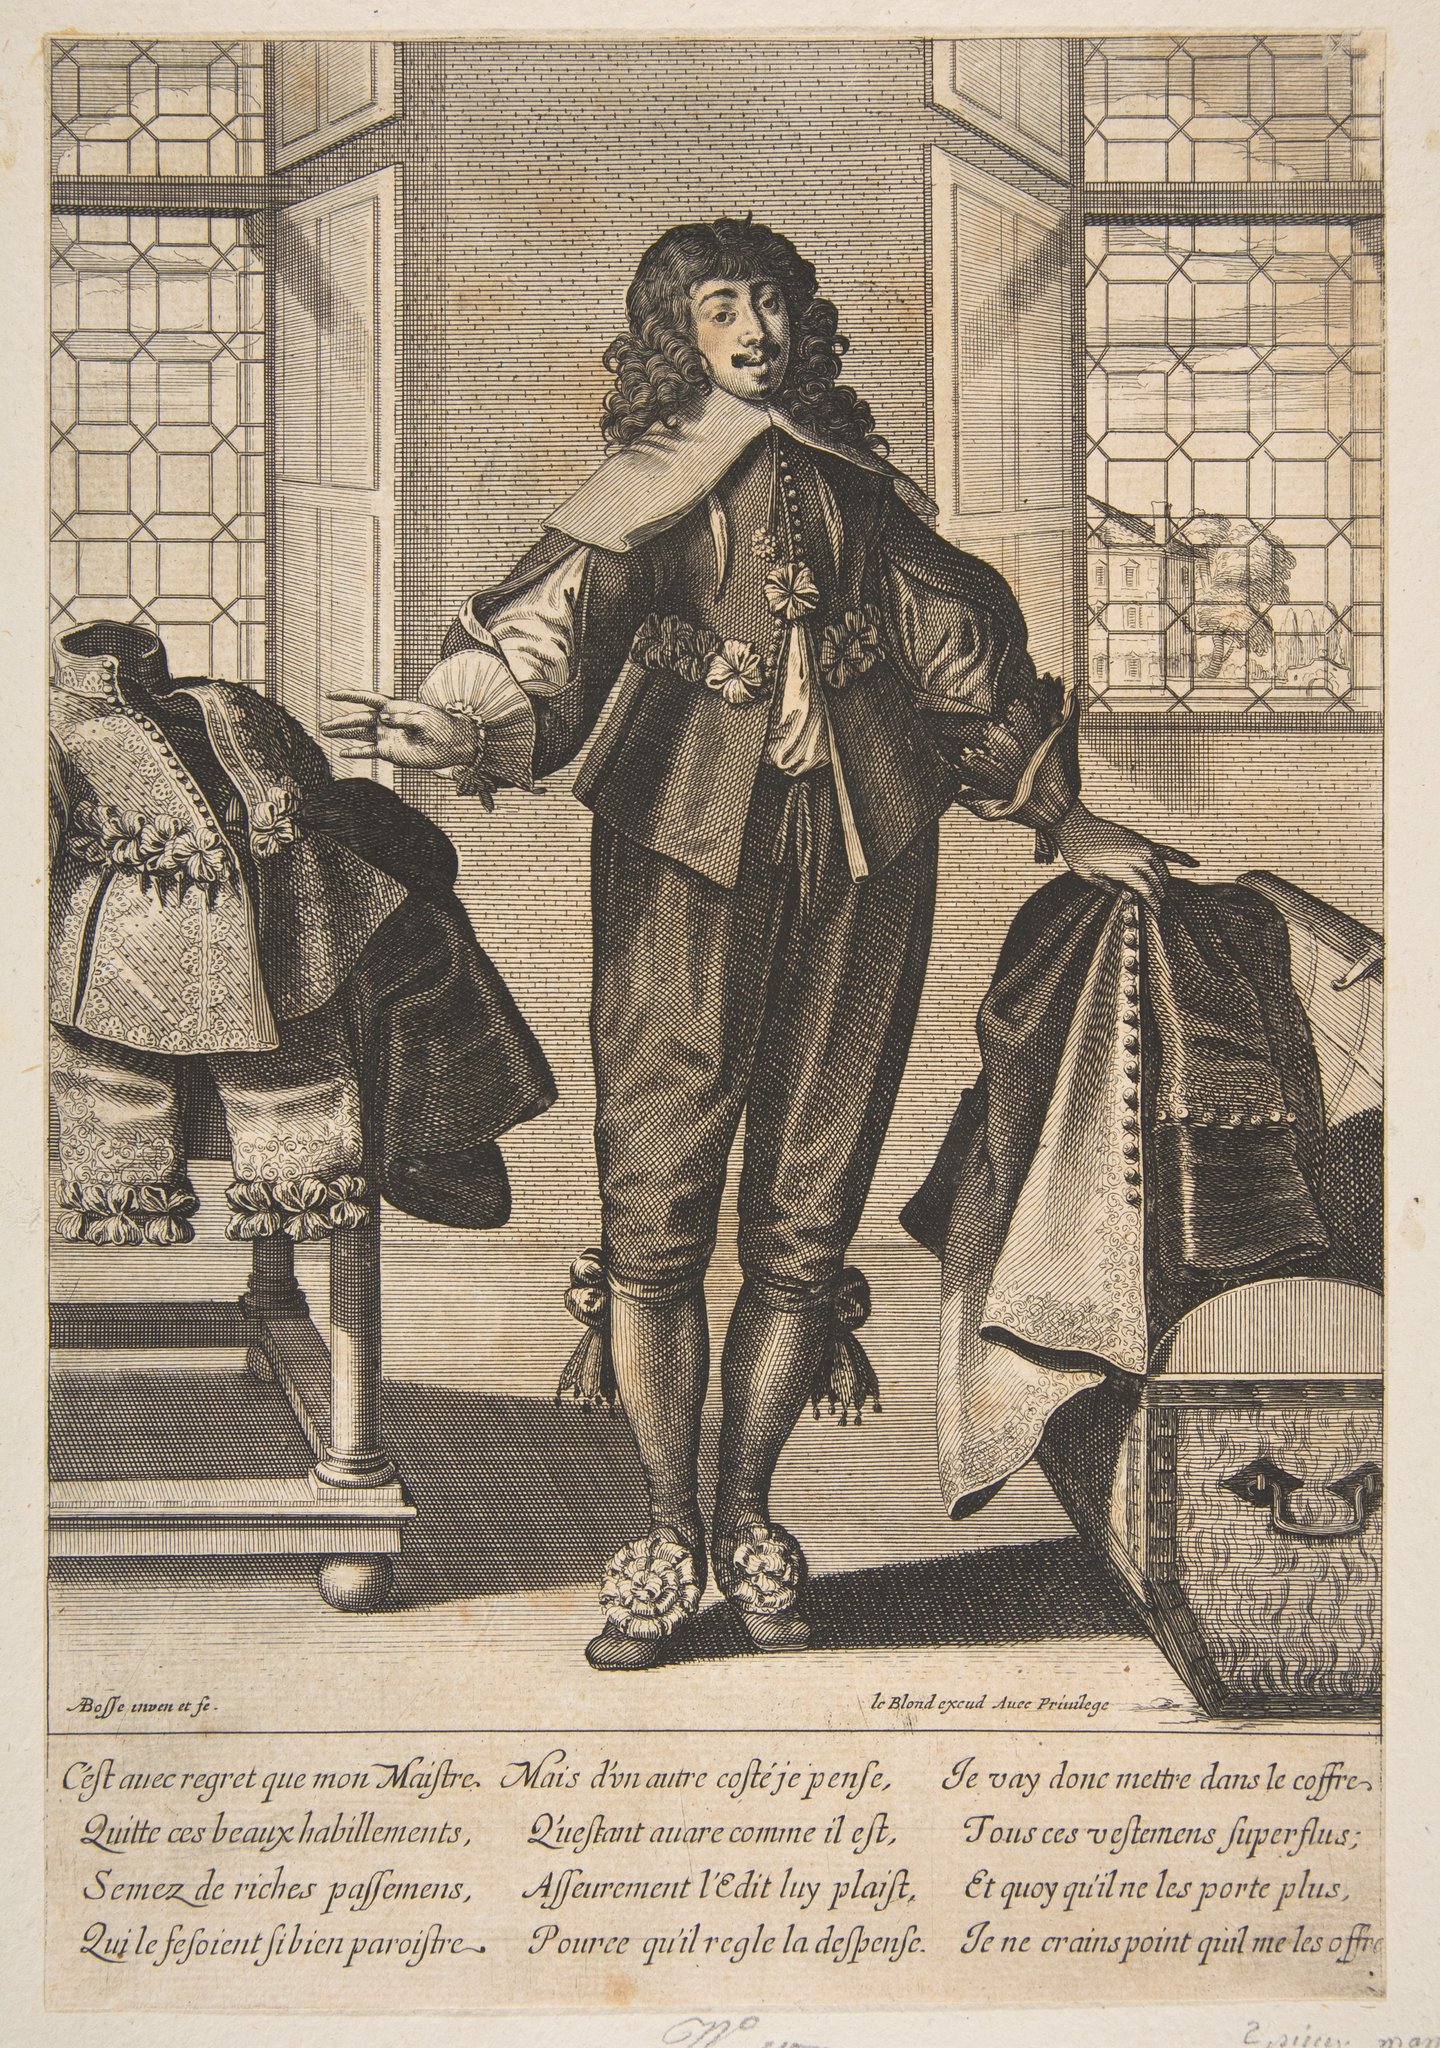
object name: print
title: A Courtier Following the Recent Edict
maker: abraham bosse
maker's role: artist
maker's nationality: french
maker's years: 1602-1676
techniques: etching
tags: men,clothing